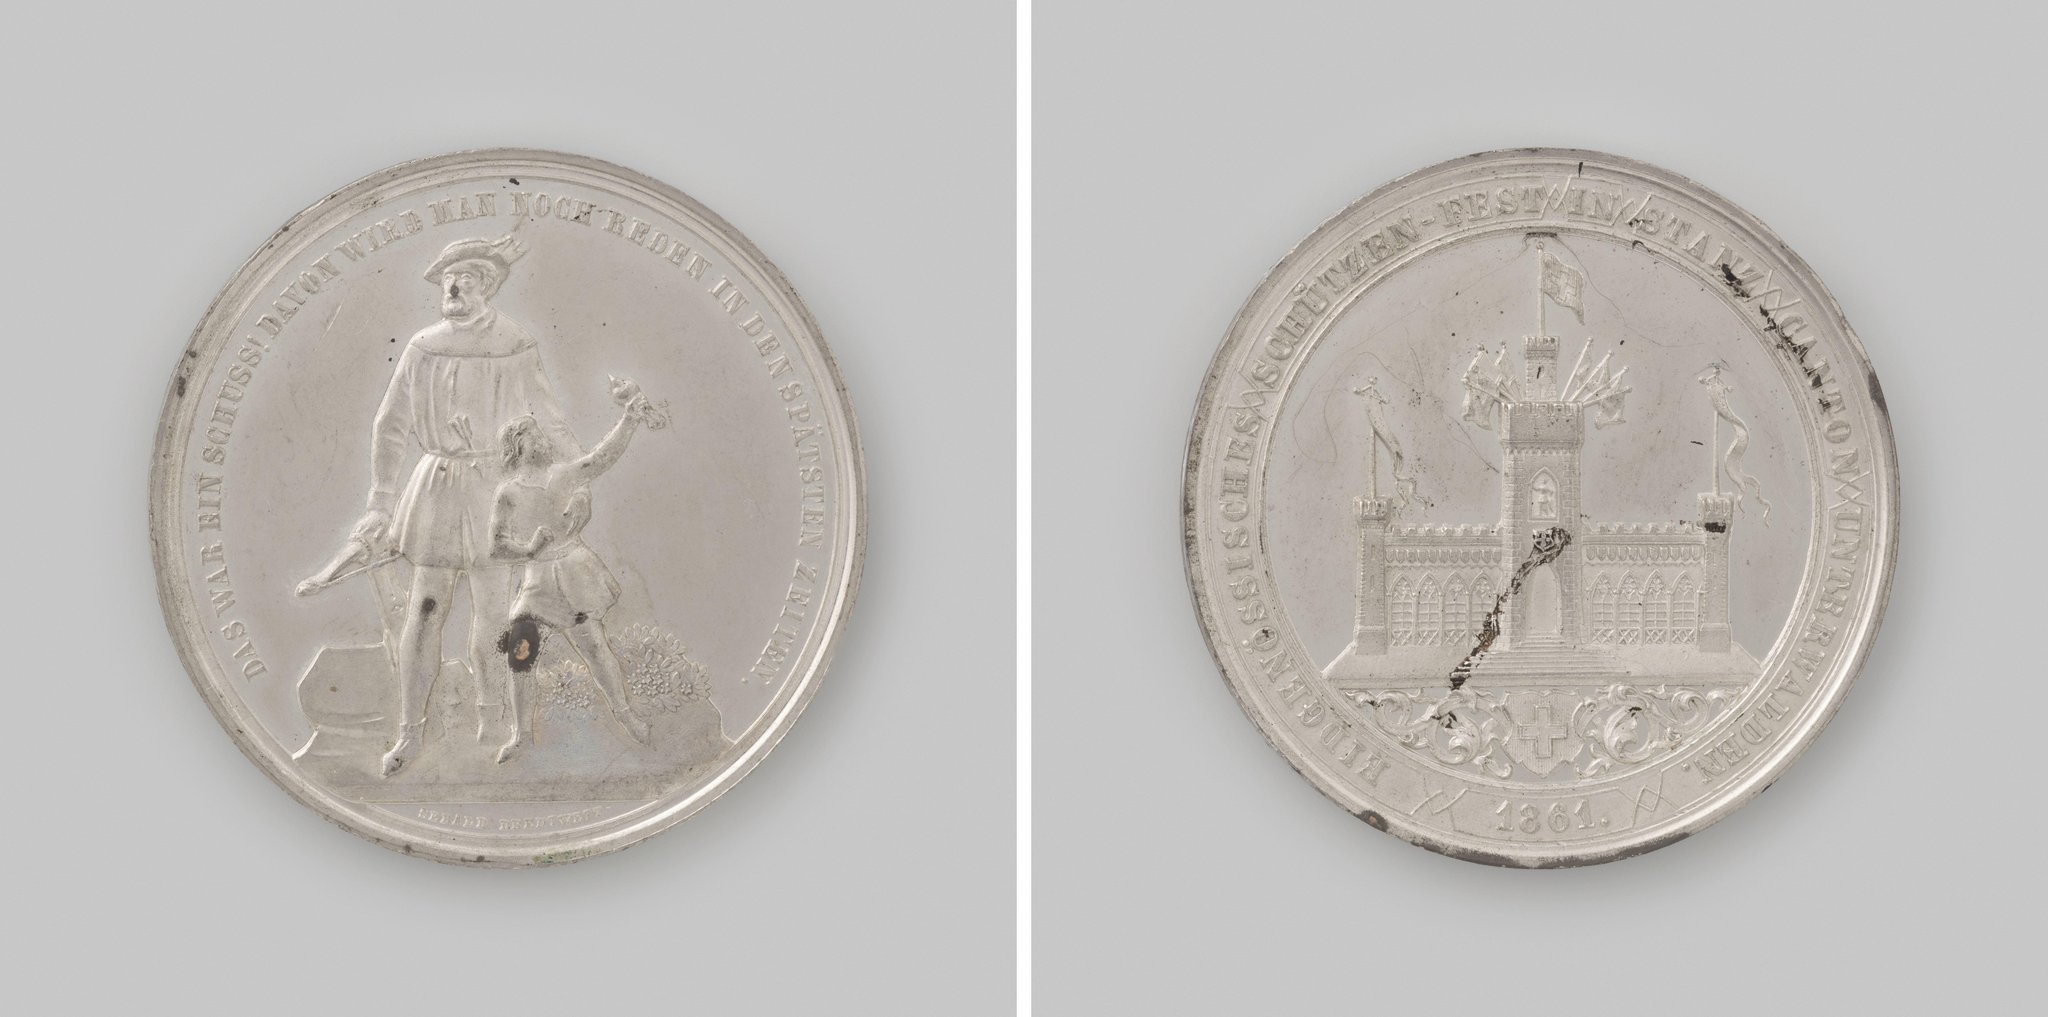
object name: marksman medal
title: Eidgenossisches Freischiessen te Stanz in het kanton Unterwalden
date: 1864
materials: silver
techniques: striking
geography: augsburg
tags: stans